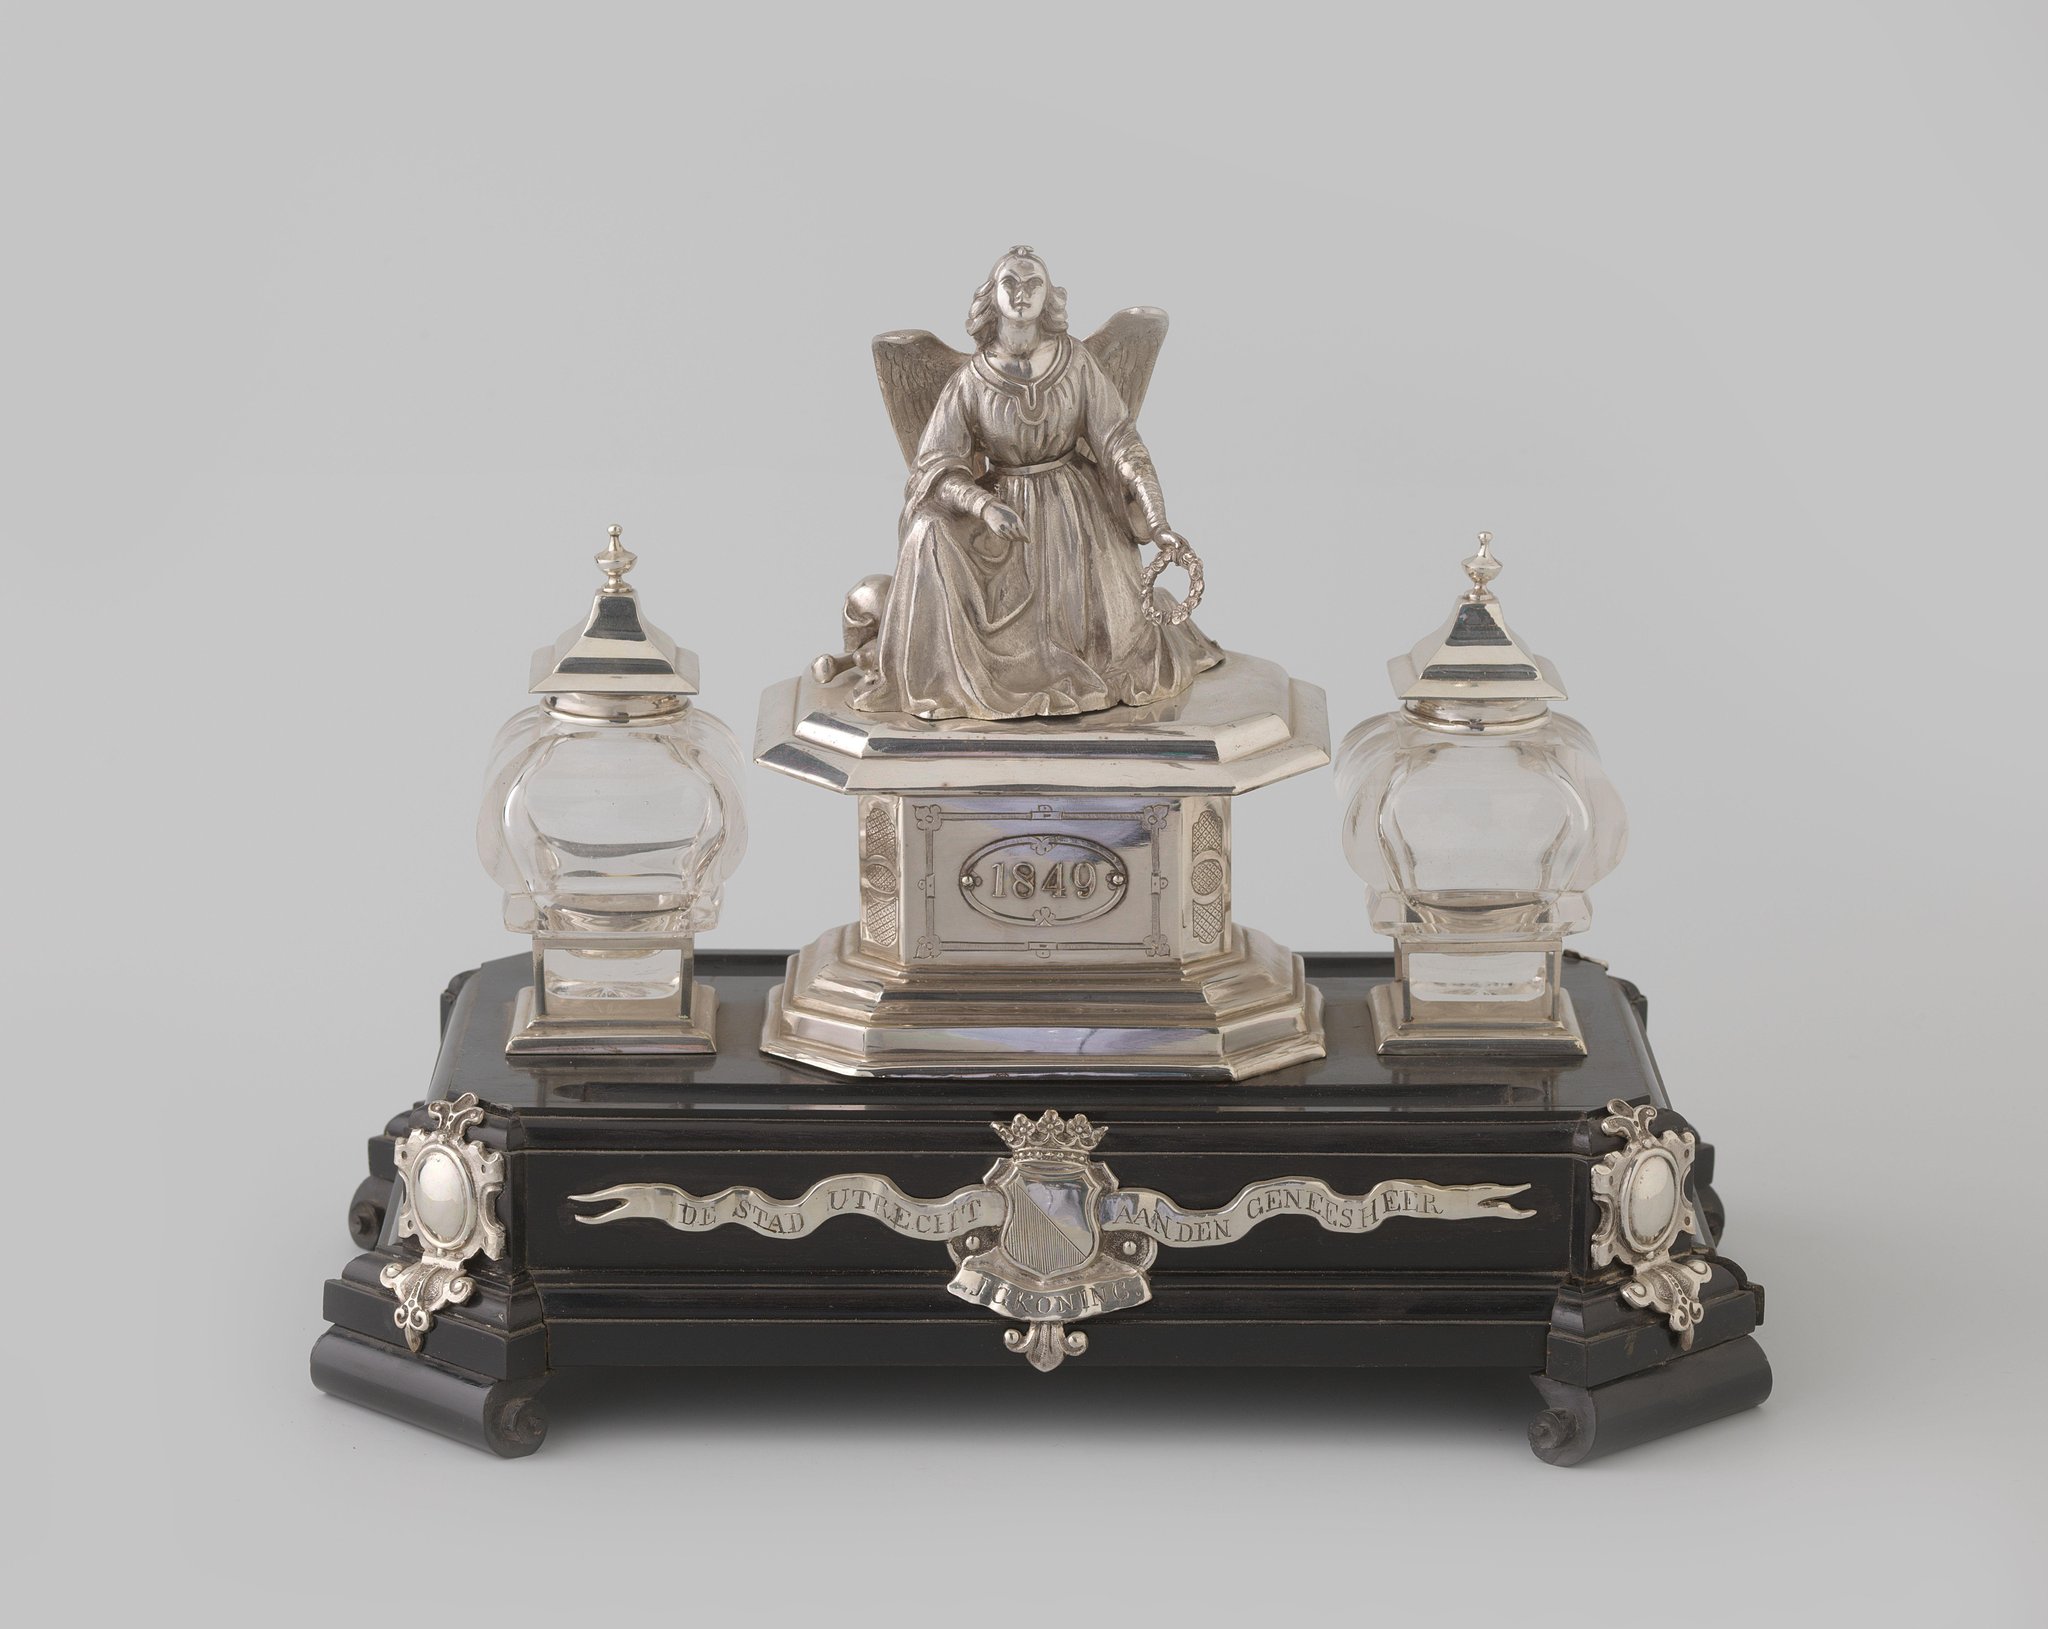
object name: inkstand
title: Inktstel geschonken door het gemeentebestuur van Utrecht aan J.C. Koning als dank voor zijn rol bij de bestrijding van de choleraepidemie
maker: johannes mattheus van kempen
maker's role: silversmith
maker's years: 1814-1877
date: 1850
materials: crystal, iron, silver, wood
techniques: manufacturing, casting, cutting, engraving, forging, striking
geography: utrecht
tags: utrecht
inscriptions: date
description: Inktstel op een zwartgelakte houten sokkel. Op de 4 hoeken van de sokkel ovalen schilden omgeven door rocaillemotieven, voorop een gekroond wapen (stadswapen Utrecht) en een lint met opschrift. Bovenop twee zilveren houdertjes waarin kristallen inktpot en zandstrooier met zilveren dekseltjes, vierkant van vorm. Tussen de potjes een zilveren sokkel waarop een engel, op het linkerbeen geknield, met ster op het hoofd, lauwerkrans in de linkerhand, naast haar rechterbeen een doodshoofd op 2 gekruiste beenderen.